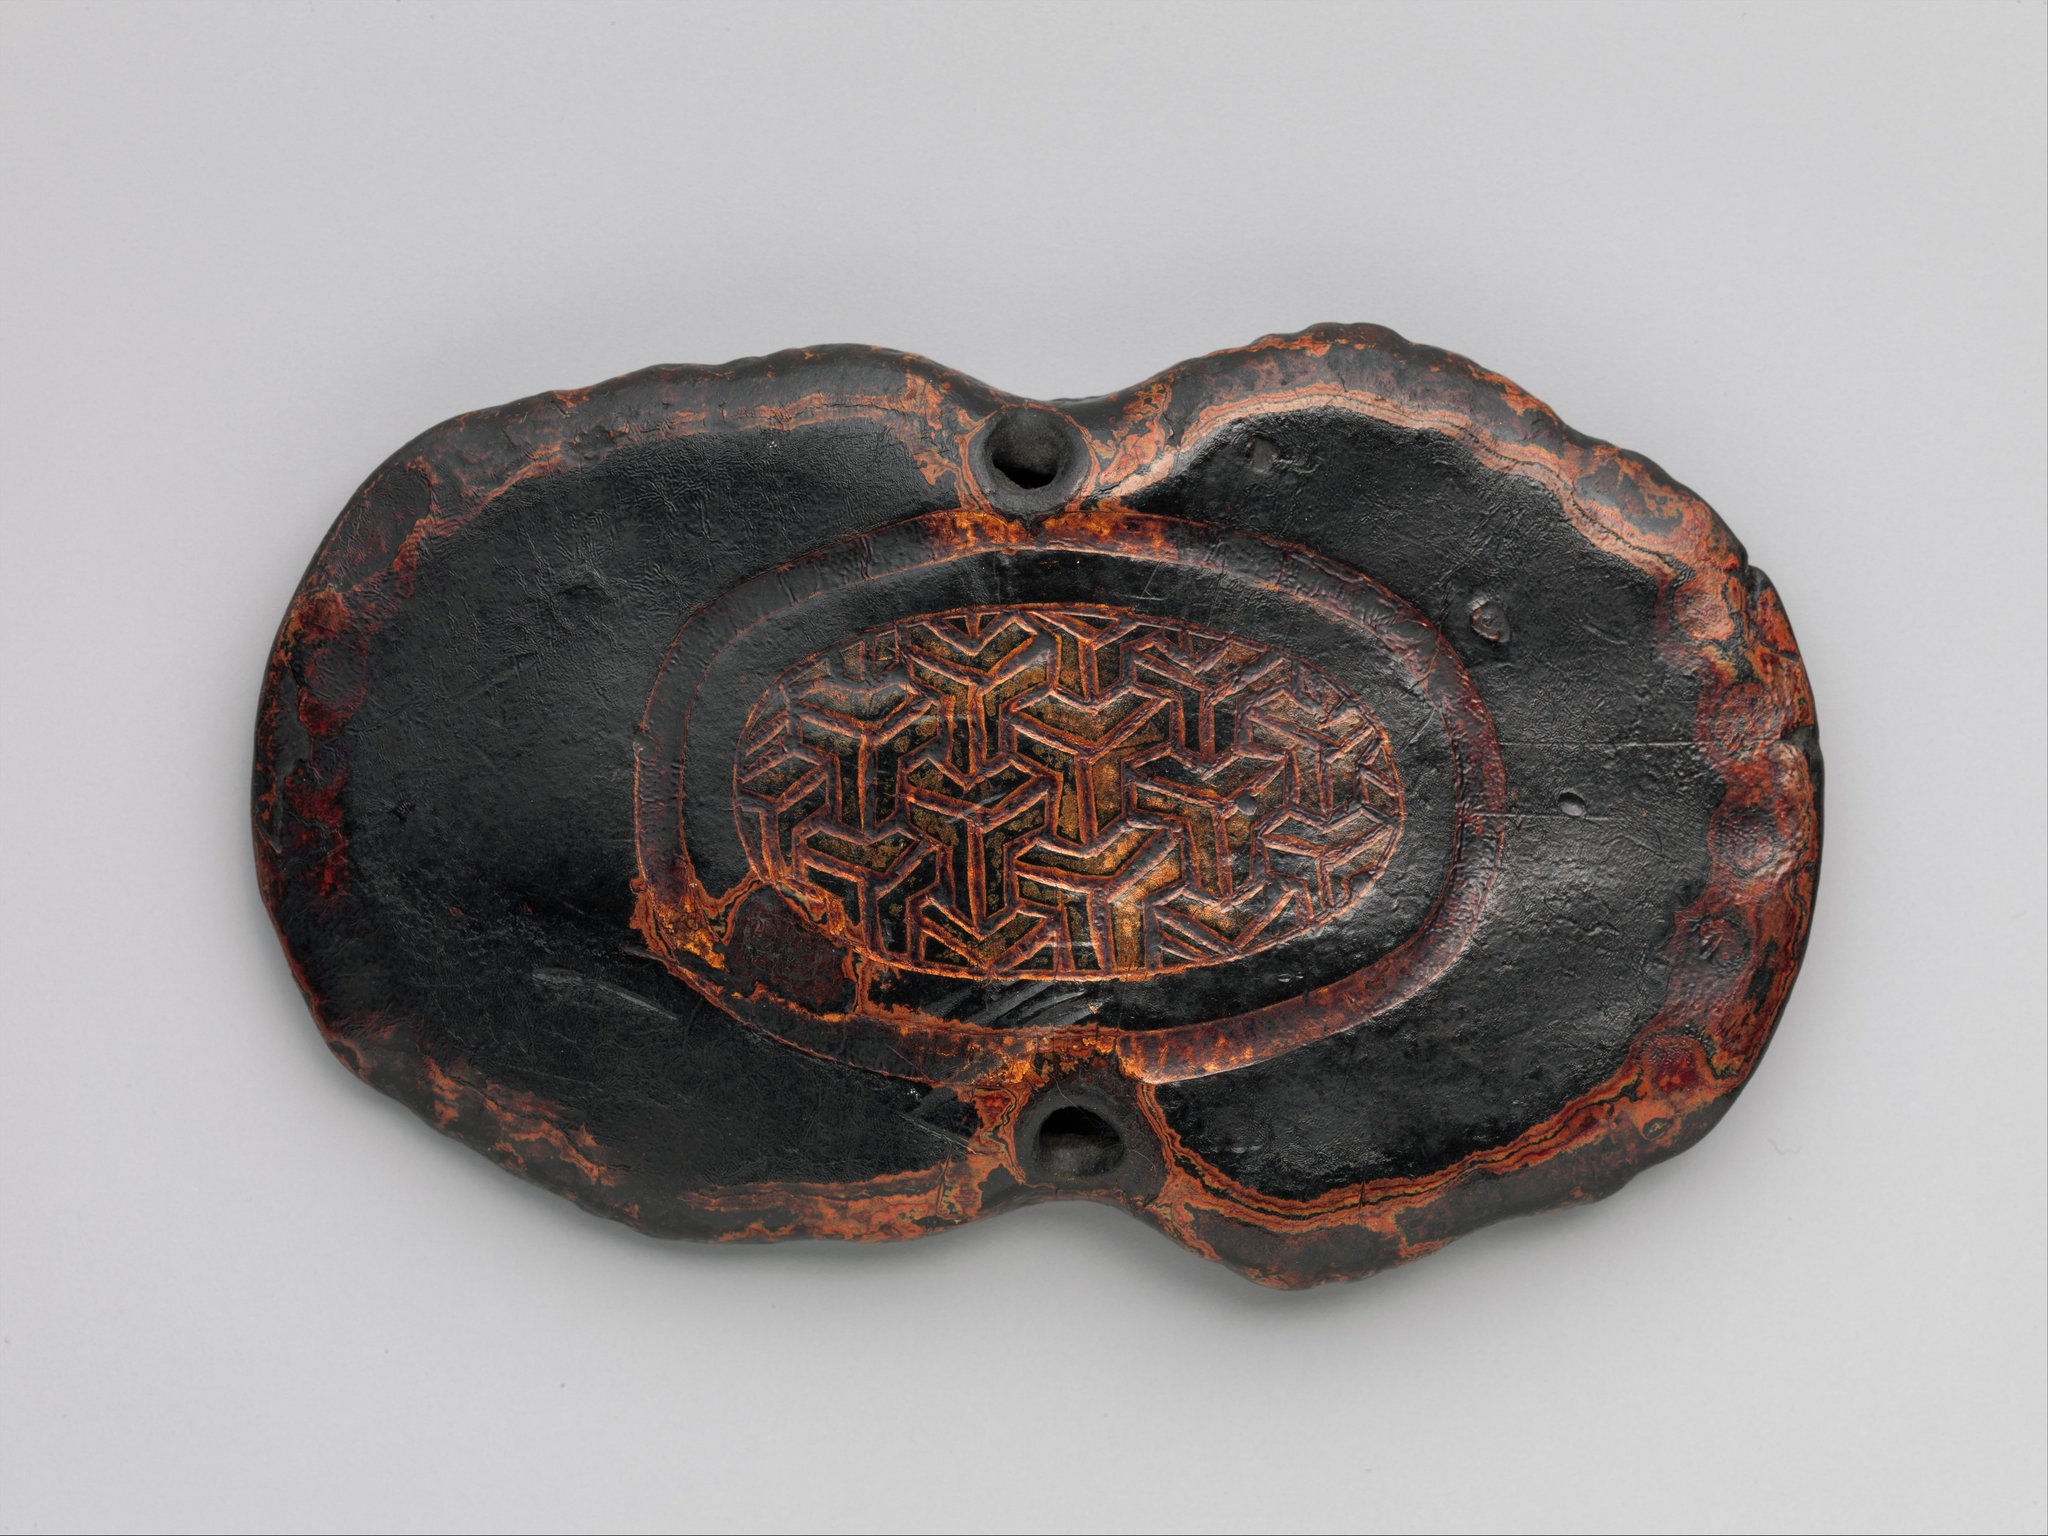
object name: archer's bracer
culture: mongolian or tibetan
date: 1401-1700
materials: gold, leather, pigment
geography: mongolia